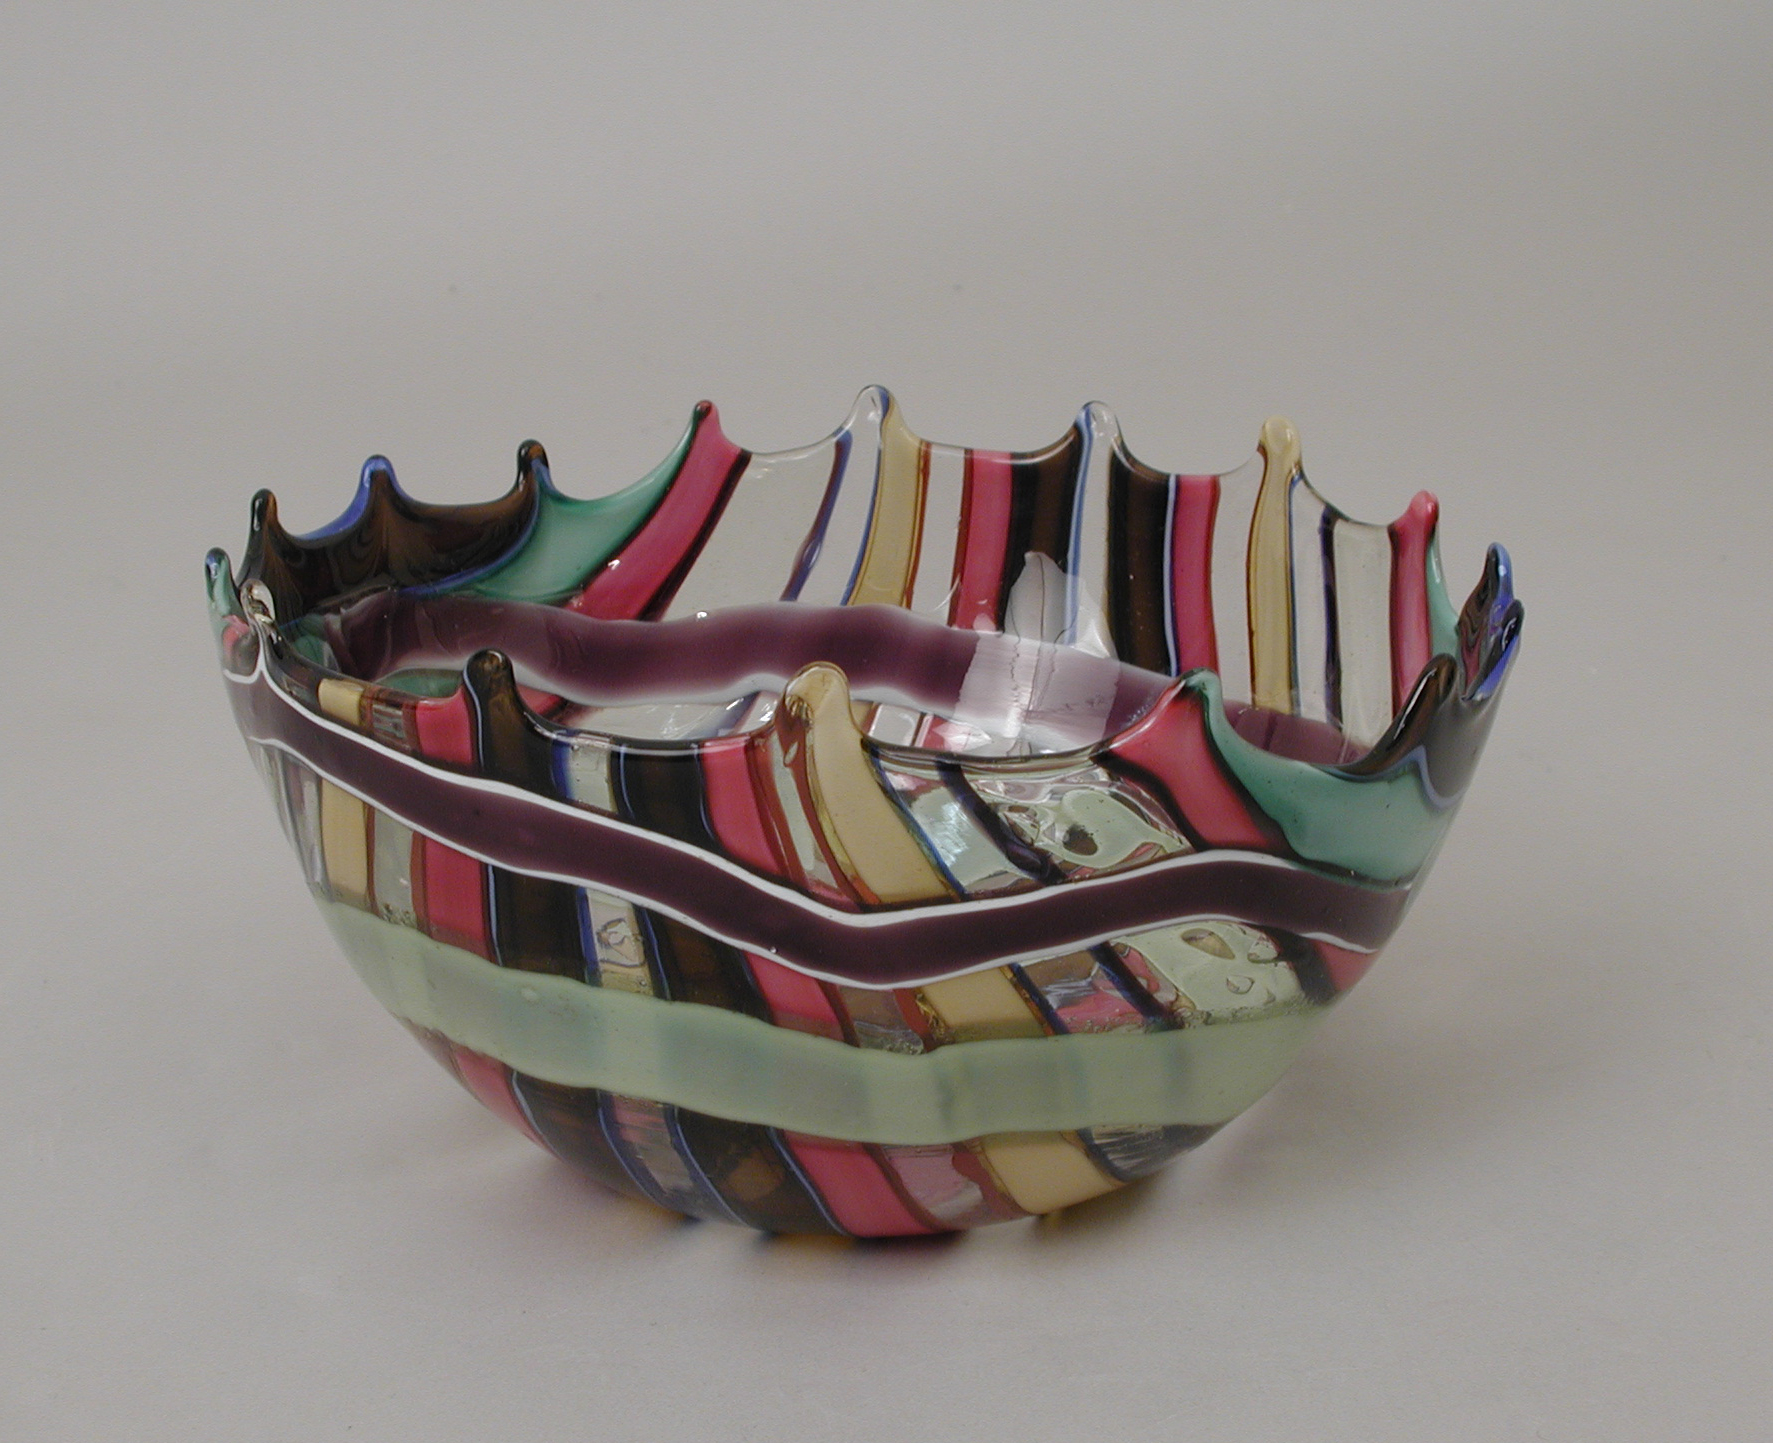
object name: bowl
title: Roman-style bowl with clear and multicolored band decoration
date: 1870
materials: glass